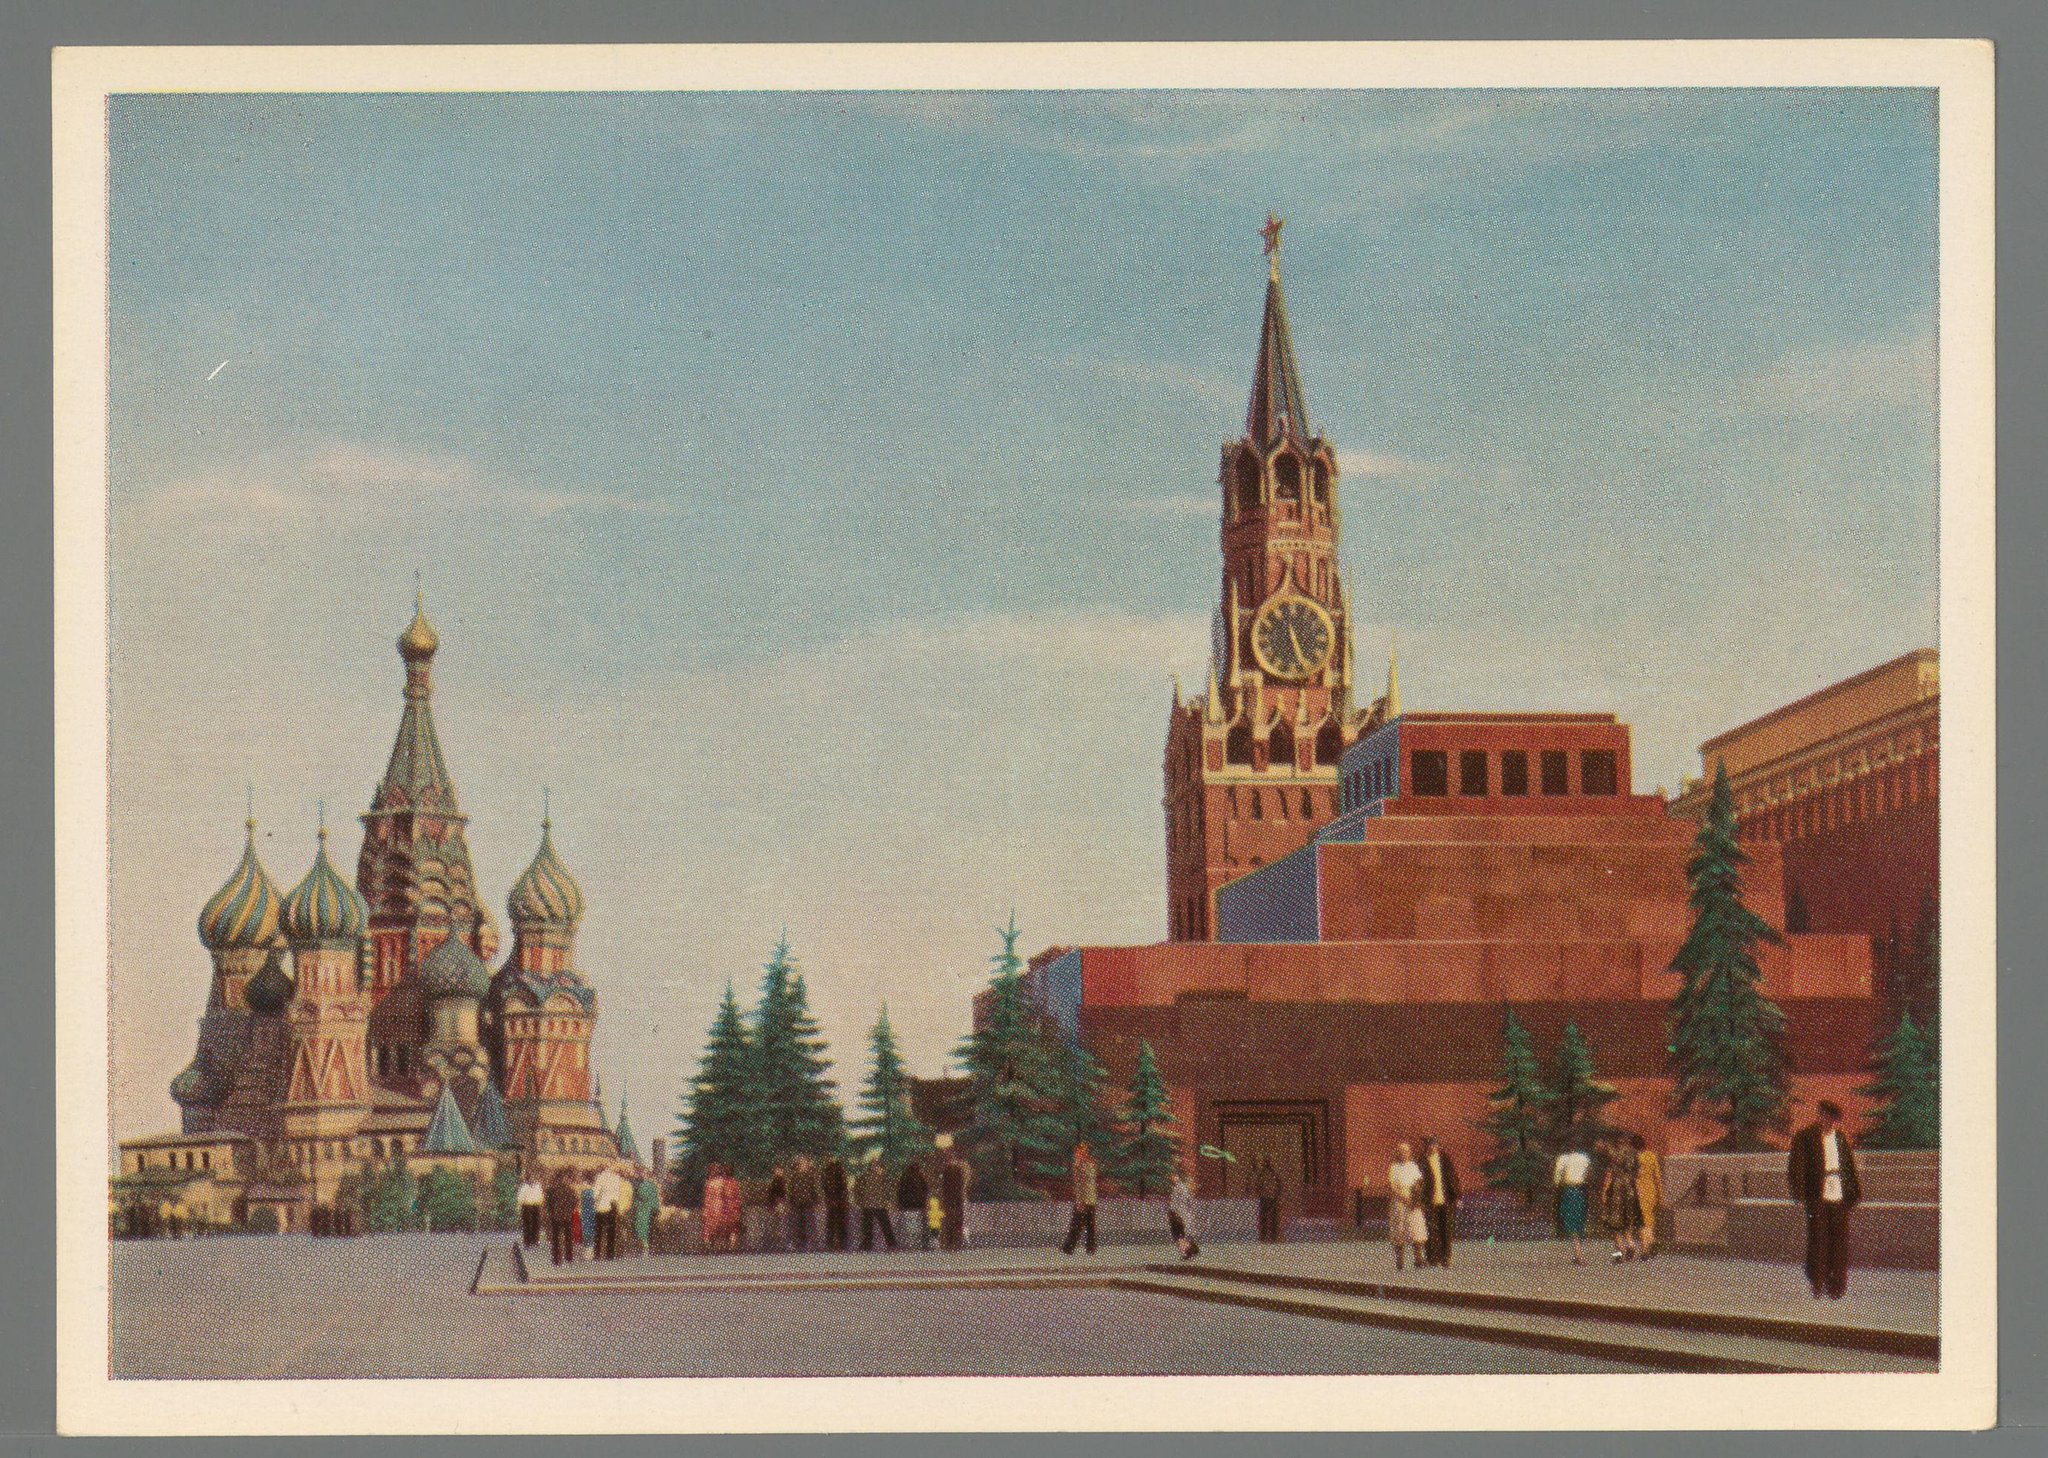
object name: ansichtkaart, prentbriefkaart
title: Moscow. Red Square. Lenin and Stalin Mausoleum / Moskau. Roter Platz. Mausoleum W.I. Lenins und J.W. Stalins / Moscou. Place Rouge. Mausolée de Lénine et de Staline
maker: Anonymous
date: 1956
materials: cardboard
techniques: color autotype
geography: moscow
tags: square, place, circus, etc., mausoleum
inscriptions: date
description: De titel op object staat ook in het Russisch.